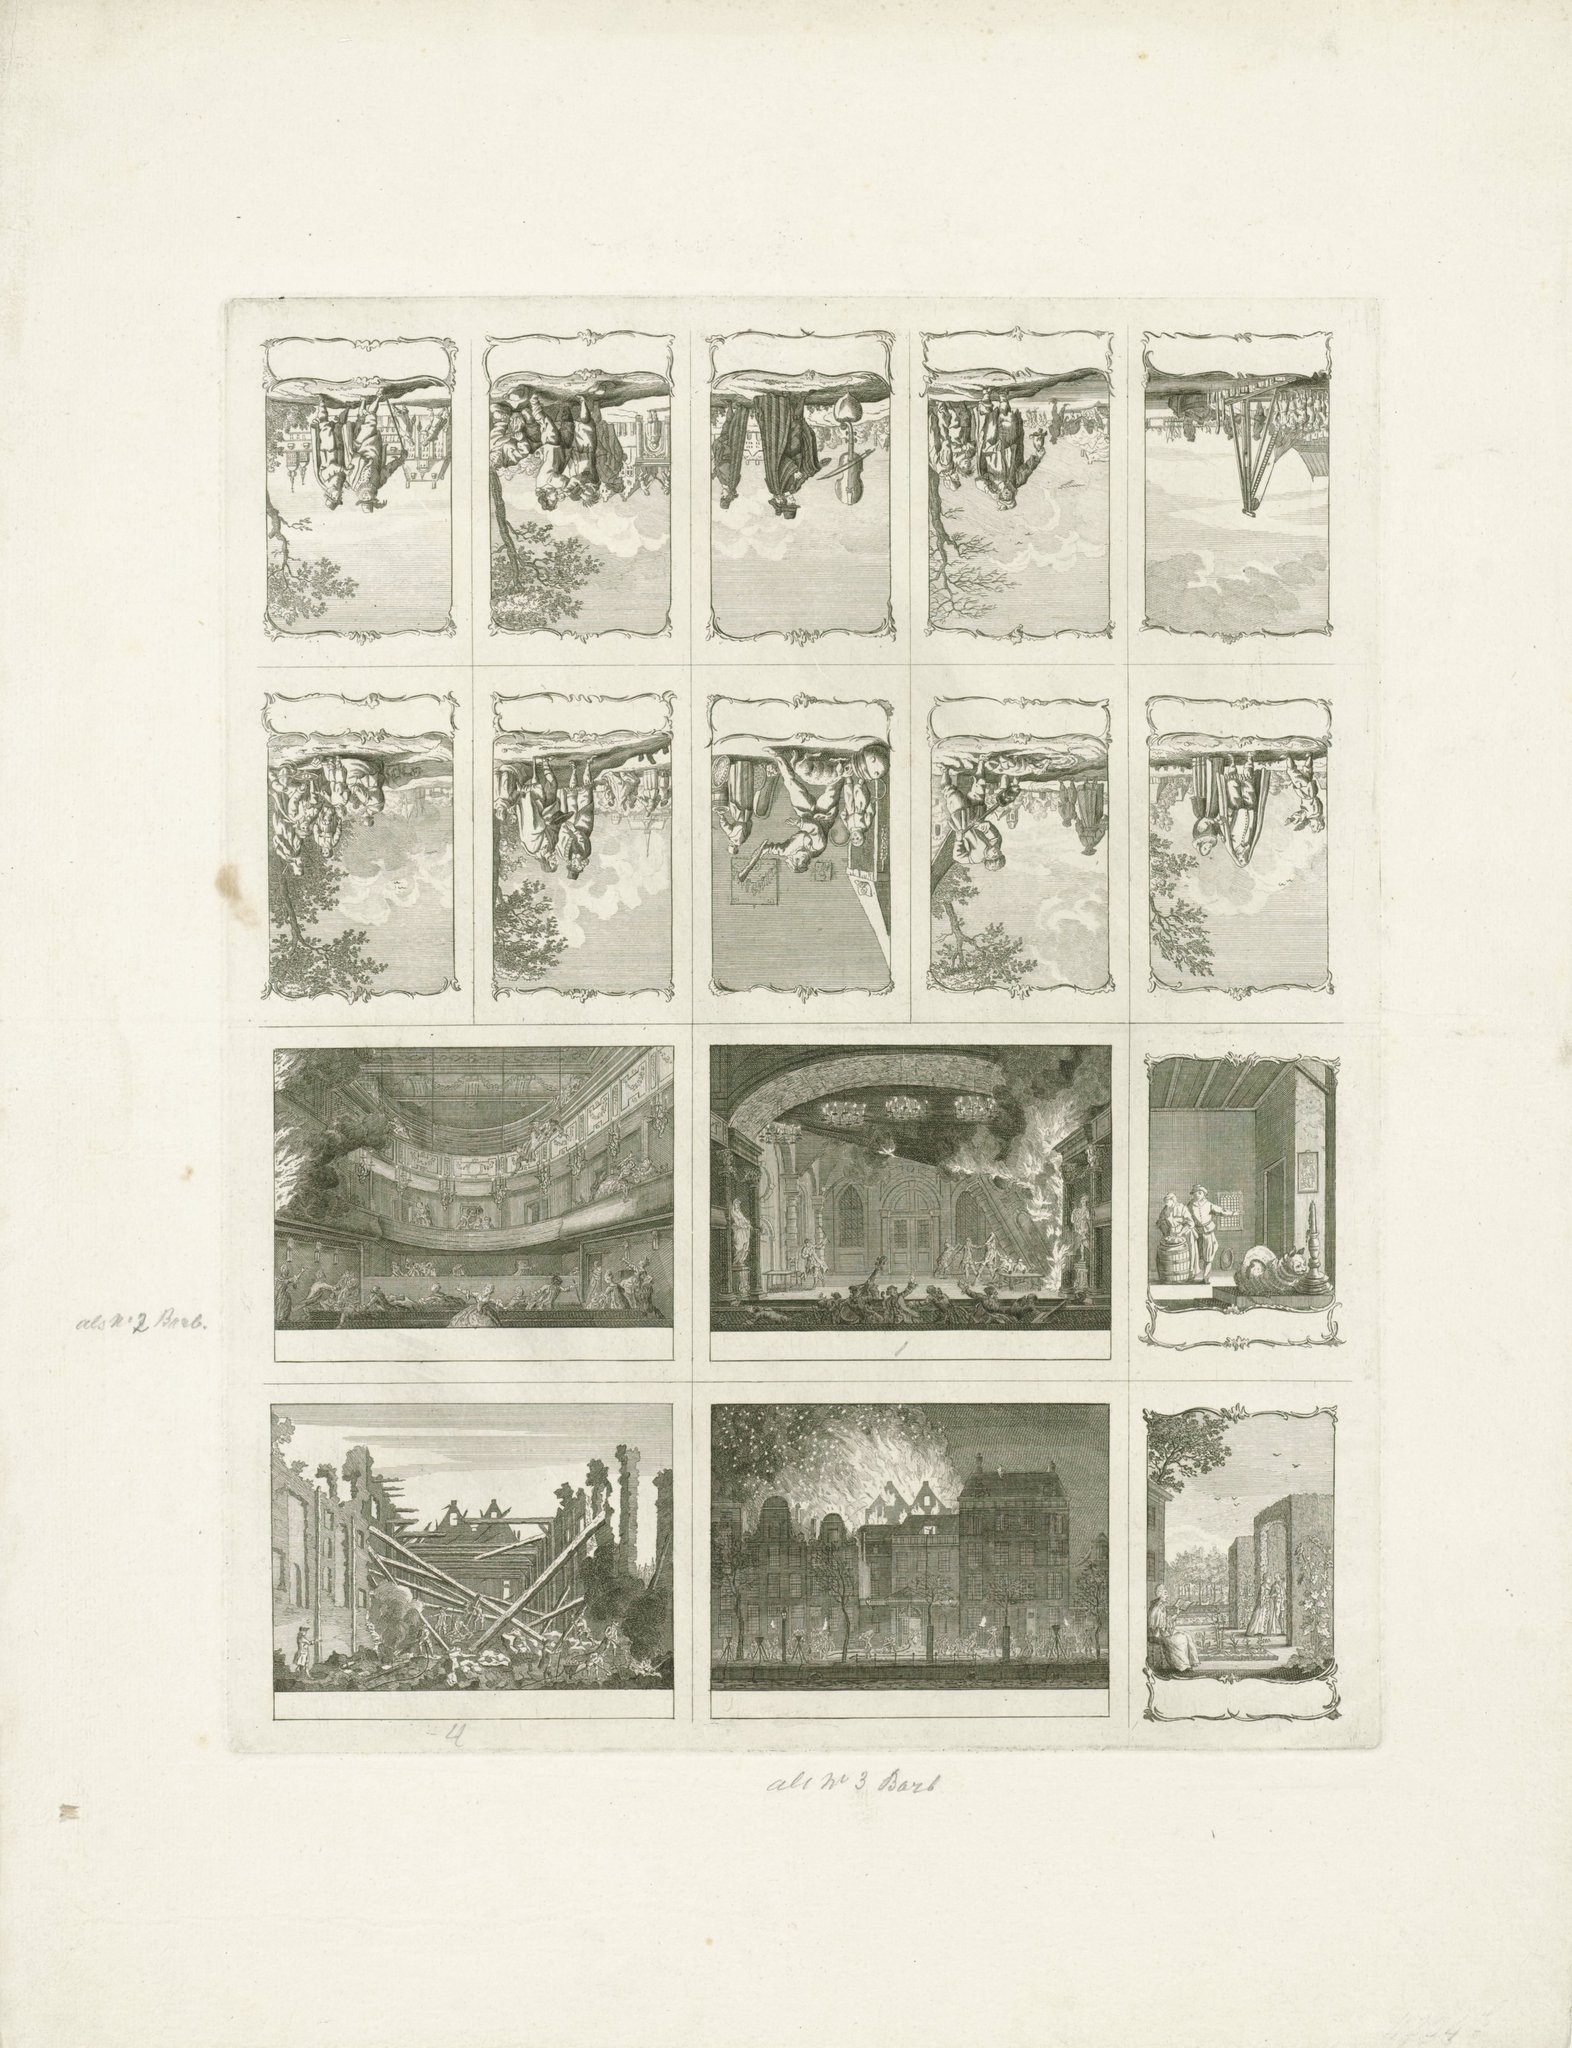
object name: print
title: Blad met 12 vignetten en 4 platen van de brand in de Amsterdamse Schouwburg, 1772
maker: Anonymous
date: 1772-1775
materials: paper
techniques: engraving, etching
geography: northern netherlands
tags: on fire, ablaze, theatre, theatrical performance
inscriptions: collector's mark: Lugt 2228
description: Onversneden blad met 16 voorstellingen: 12 vignetten met spreekwoorden in krullijst en 4 platen van de brand in de Amsterdamse Schouwburg op 11 mei 1772.